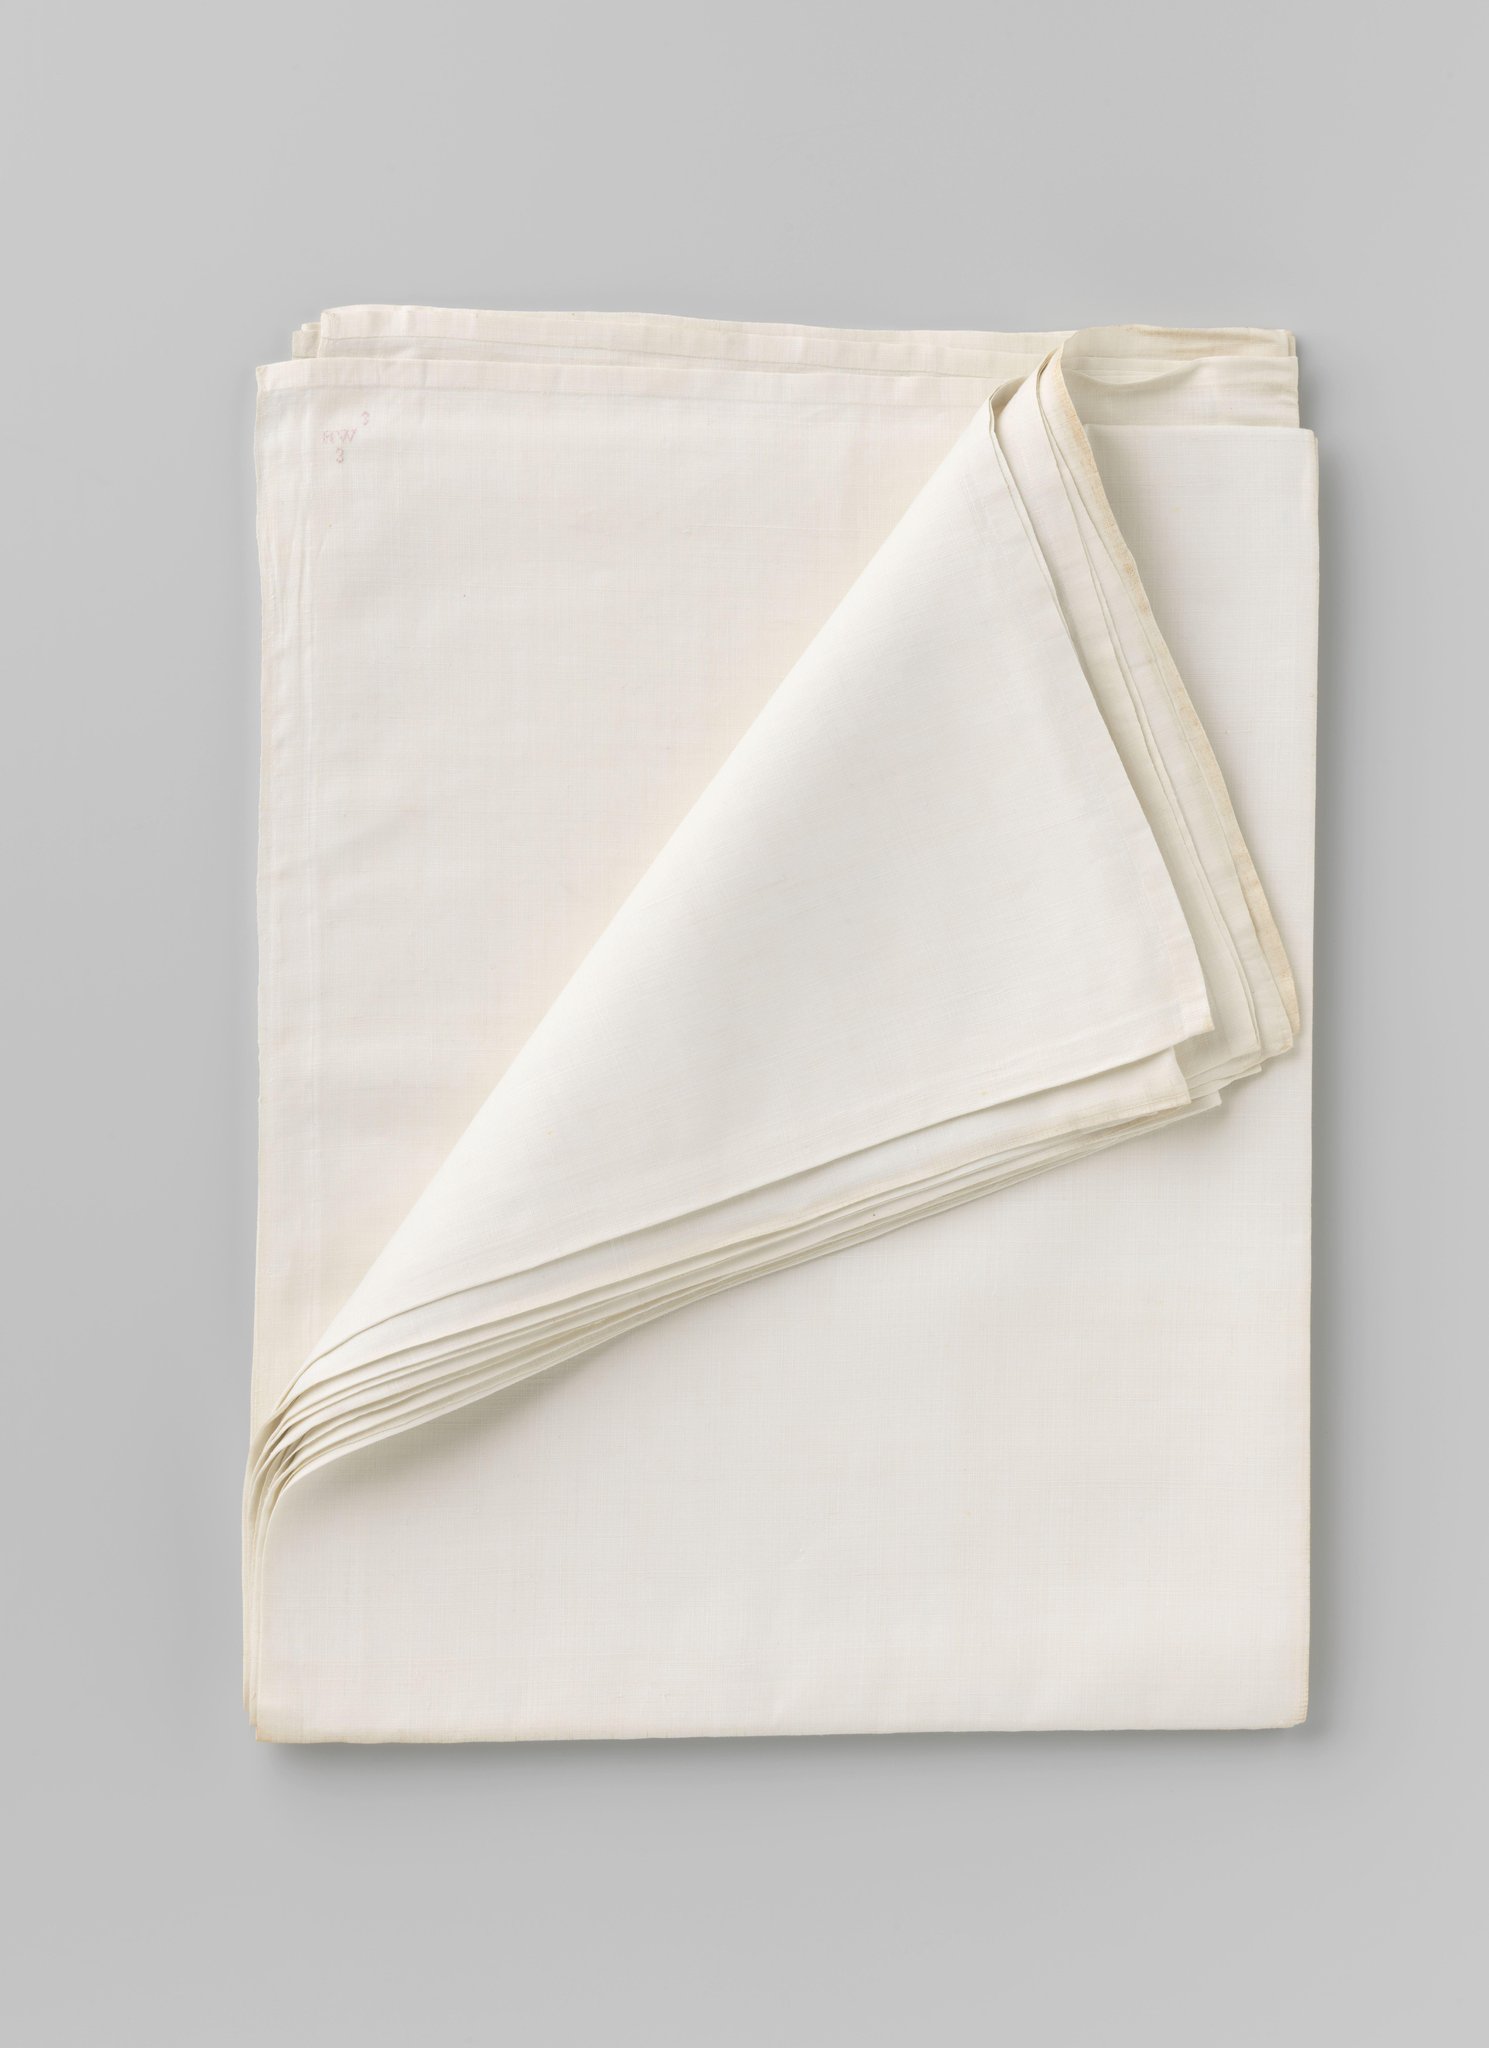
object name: beddenlaken, laken object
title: Laken. Merk: HW33.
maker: Anonymous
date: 1700-1800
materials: linen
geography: northern netherlands